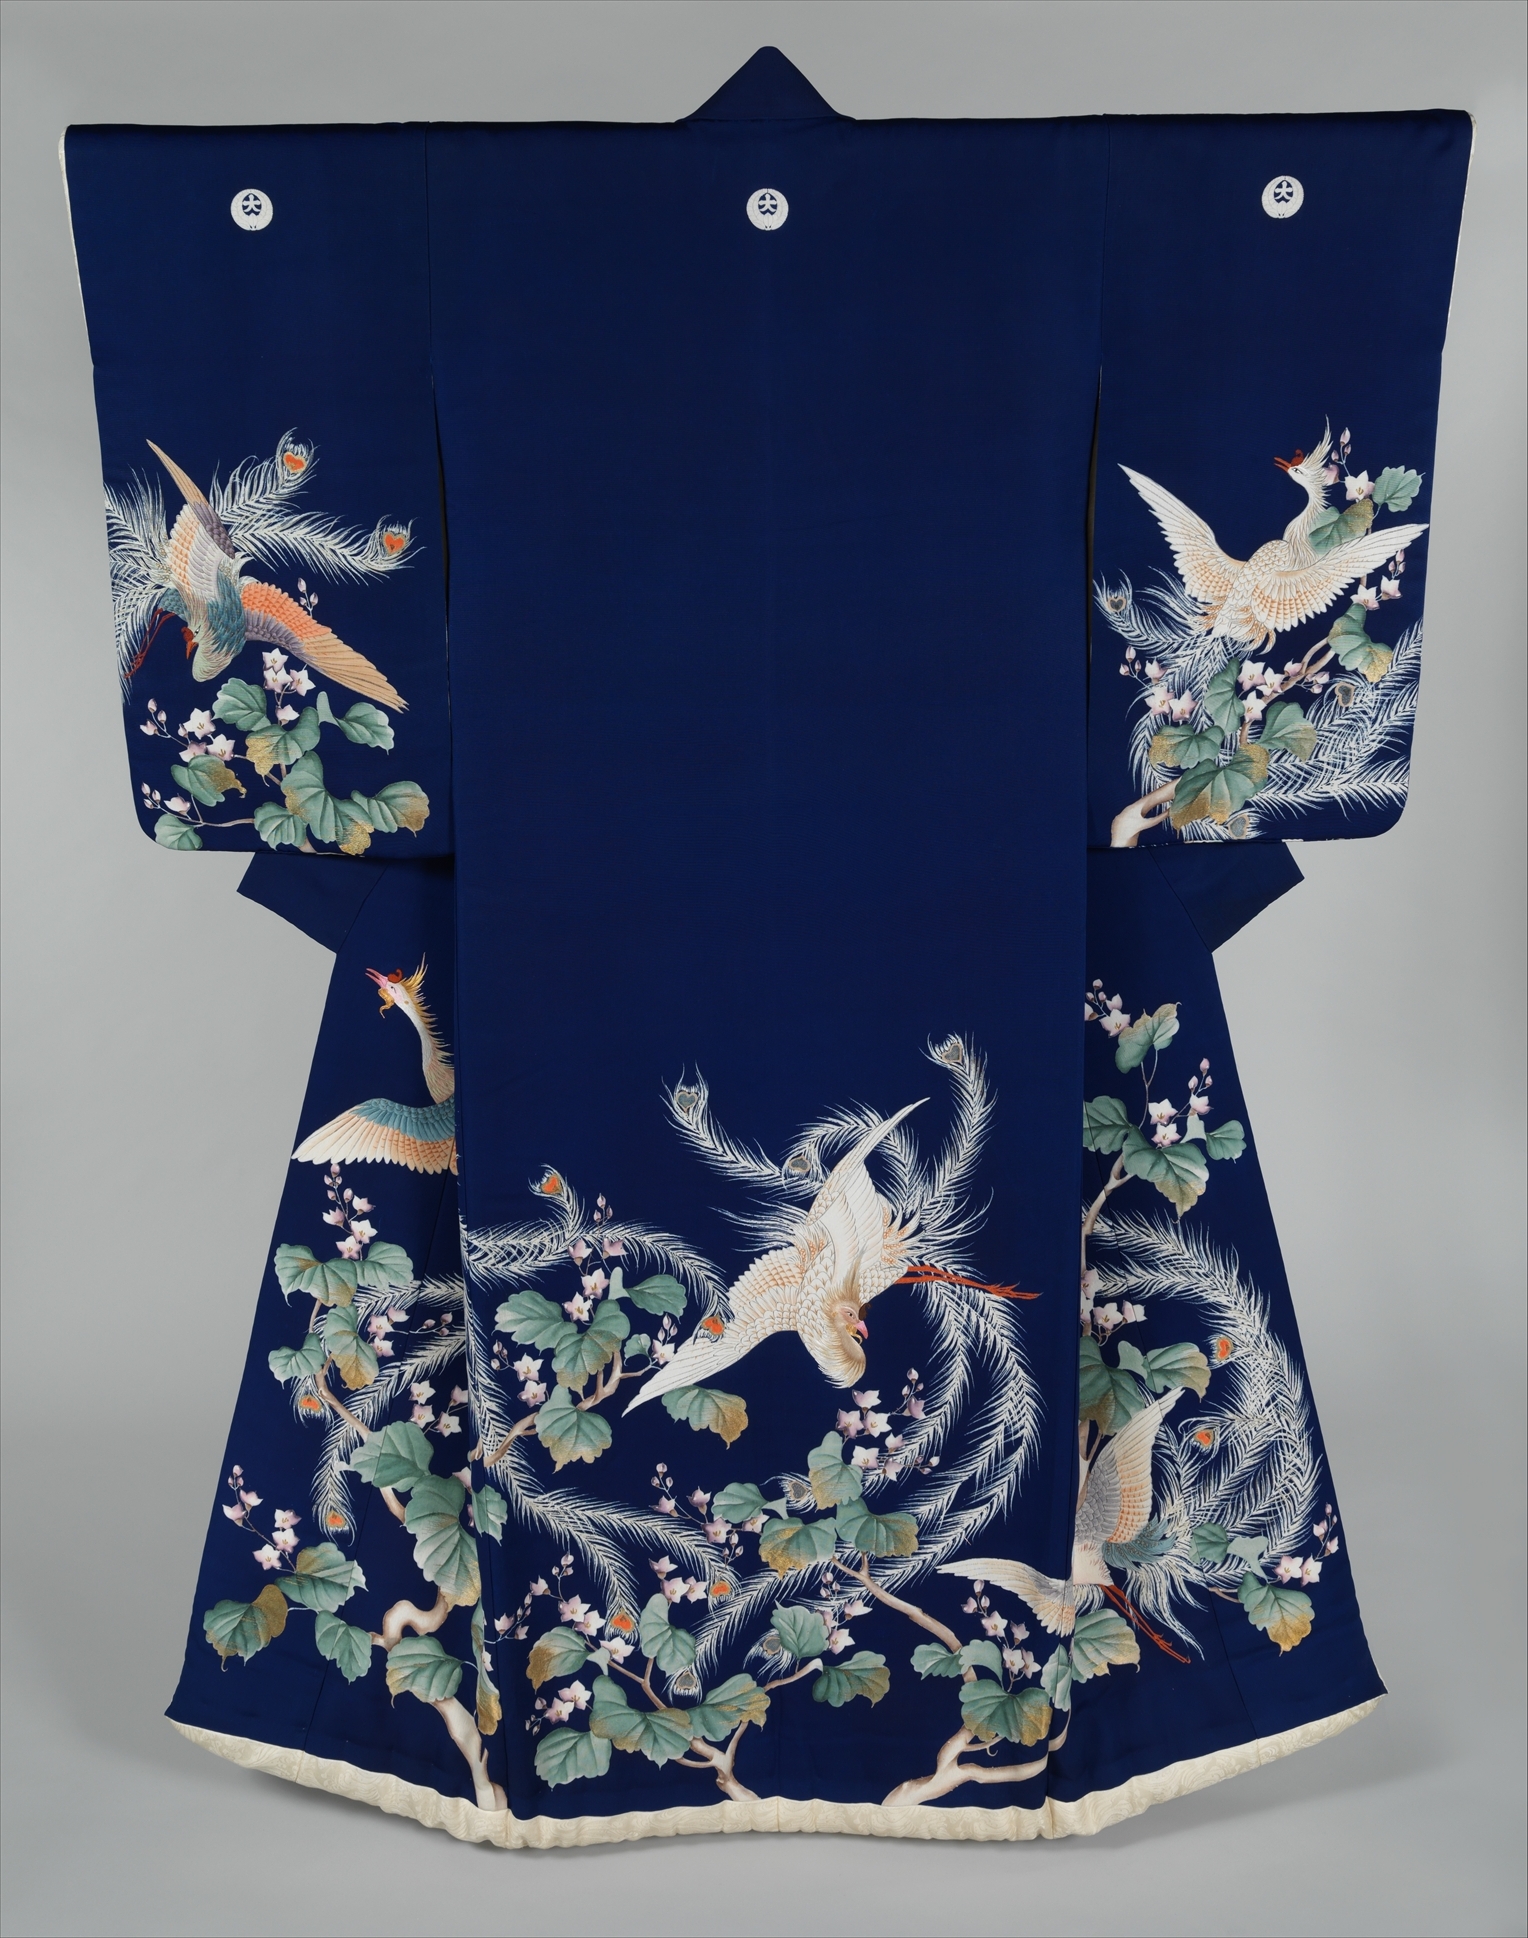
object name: outer robe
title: Outer Robe (Uchikake) with Phoenixes and Paulownia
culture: japanese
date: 1901-1933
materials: gold thread, silk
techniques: dyeing, embroidery, painting, weave, resist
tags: phoenix